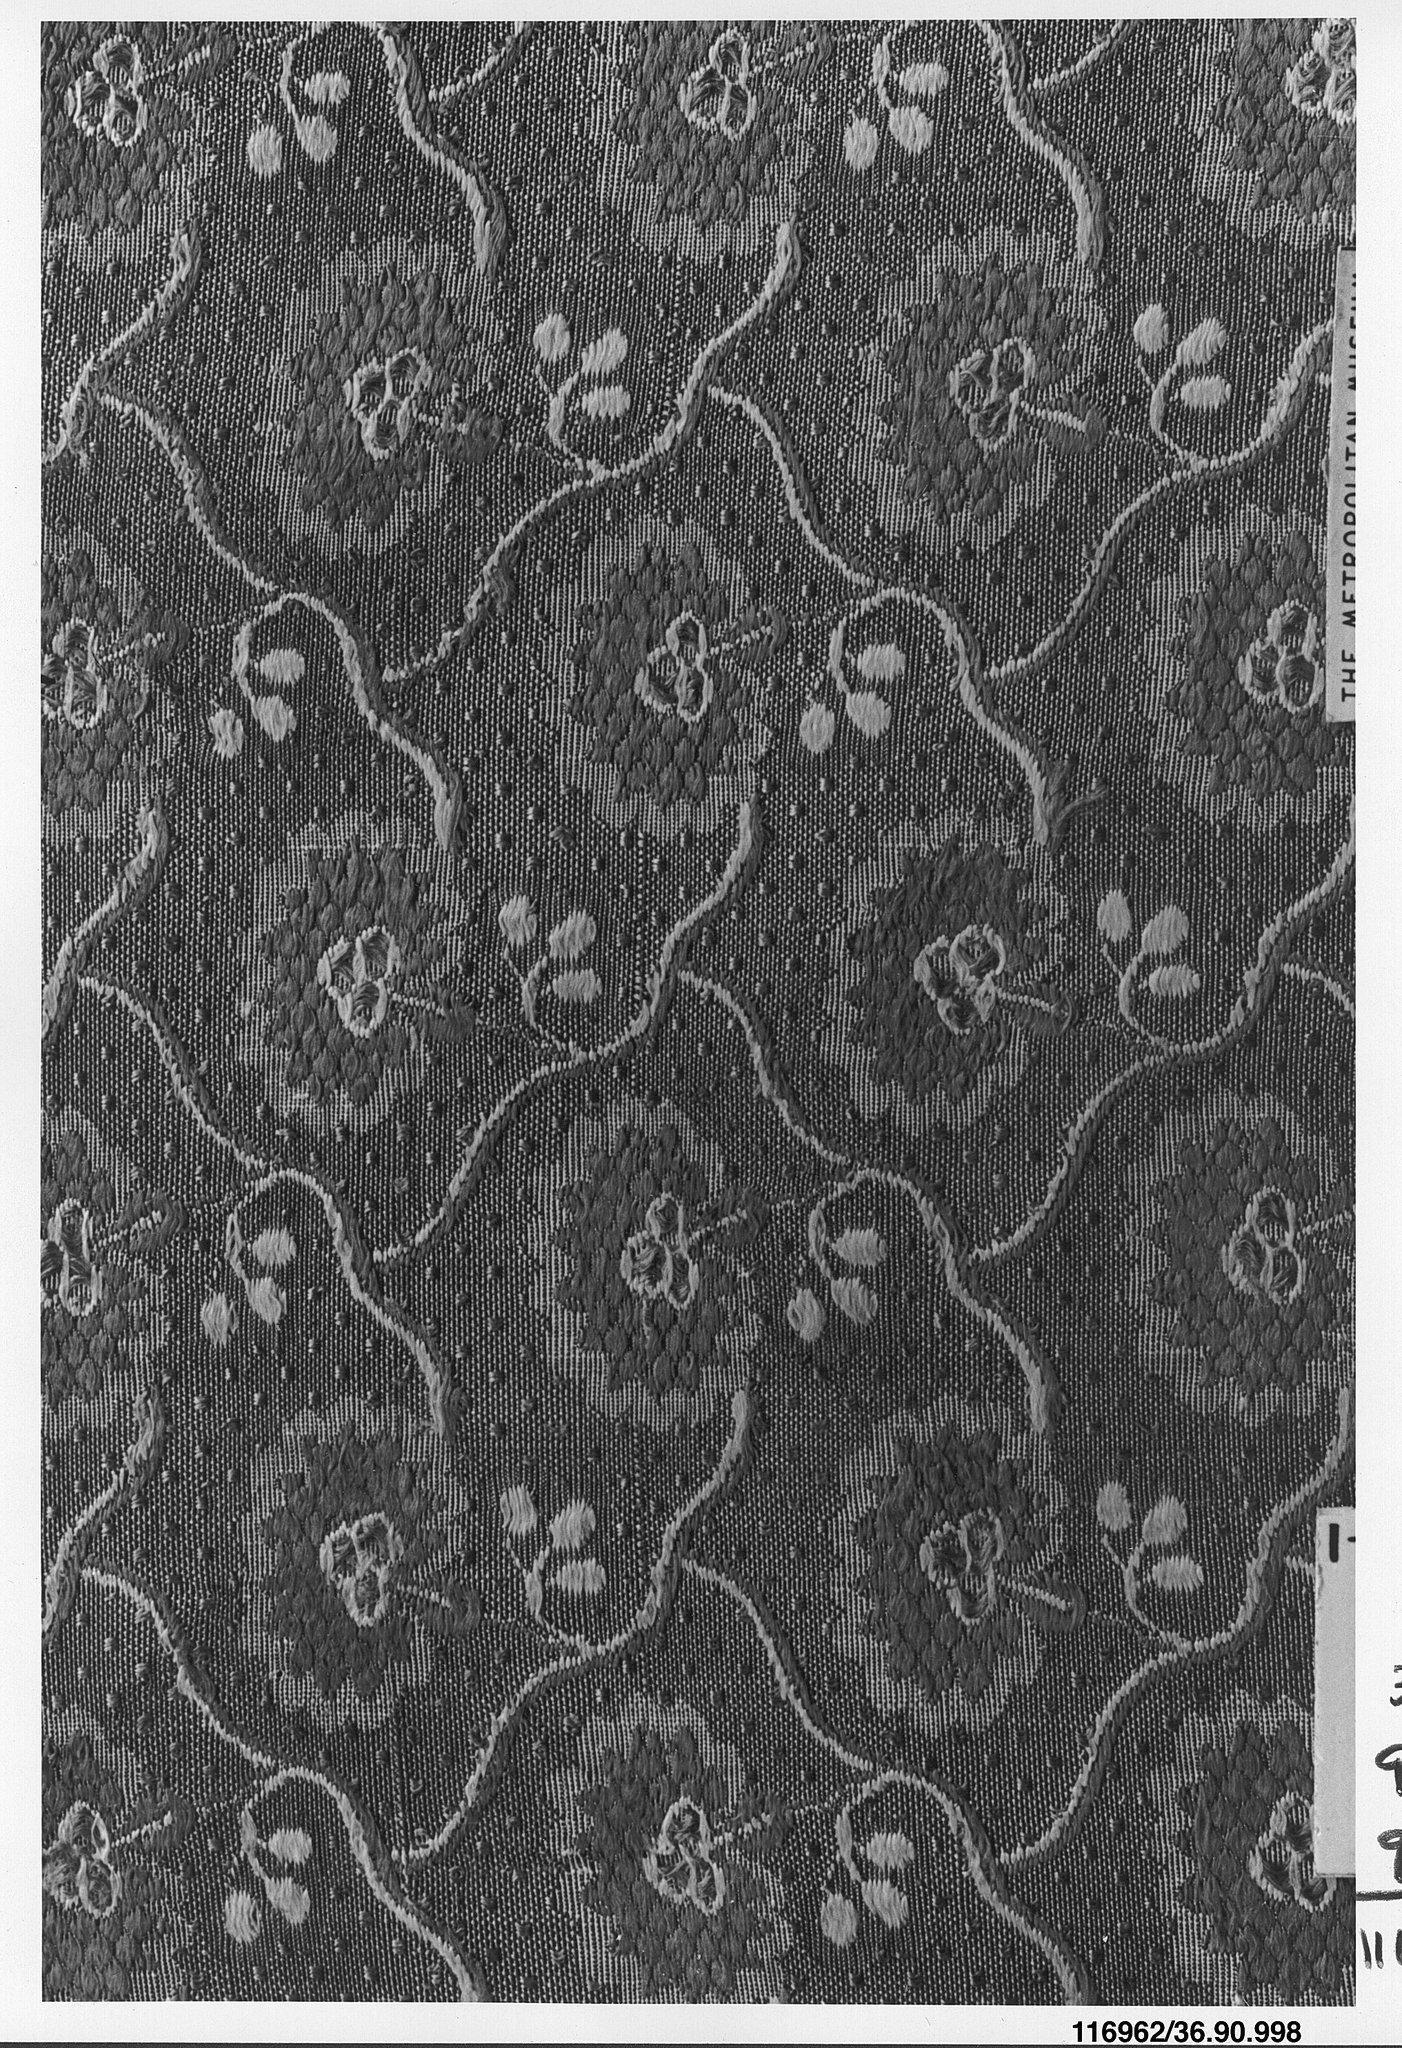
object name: piece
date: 1701-1800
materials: silk